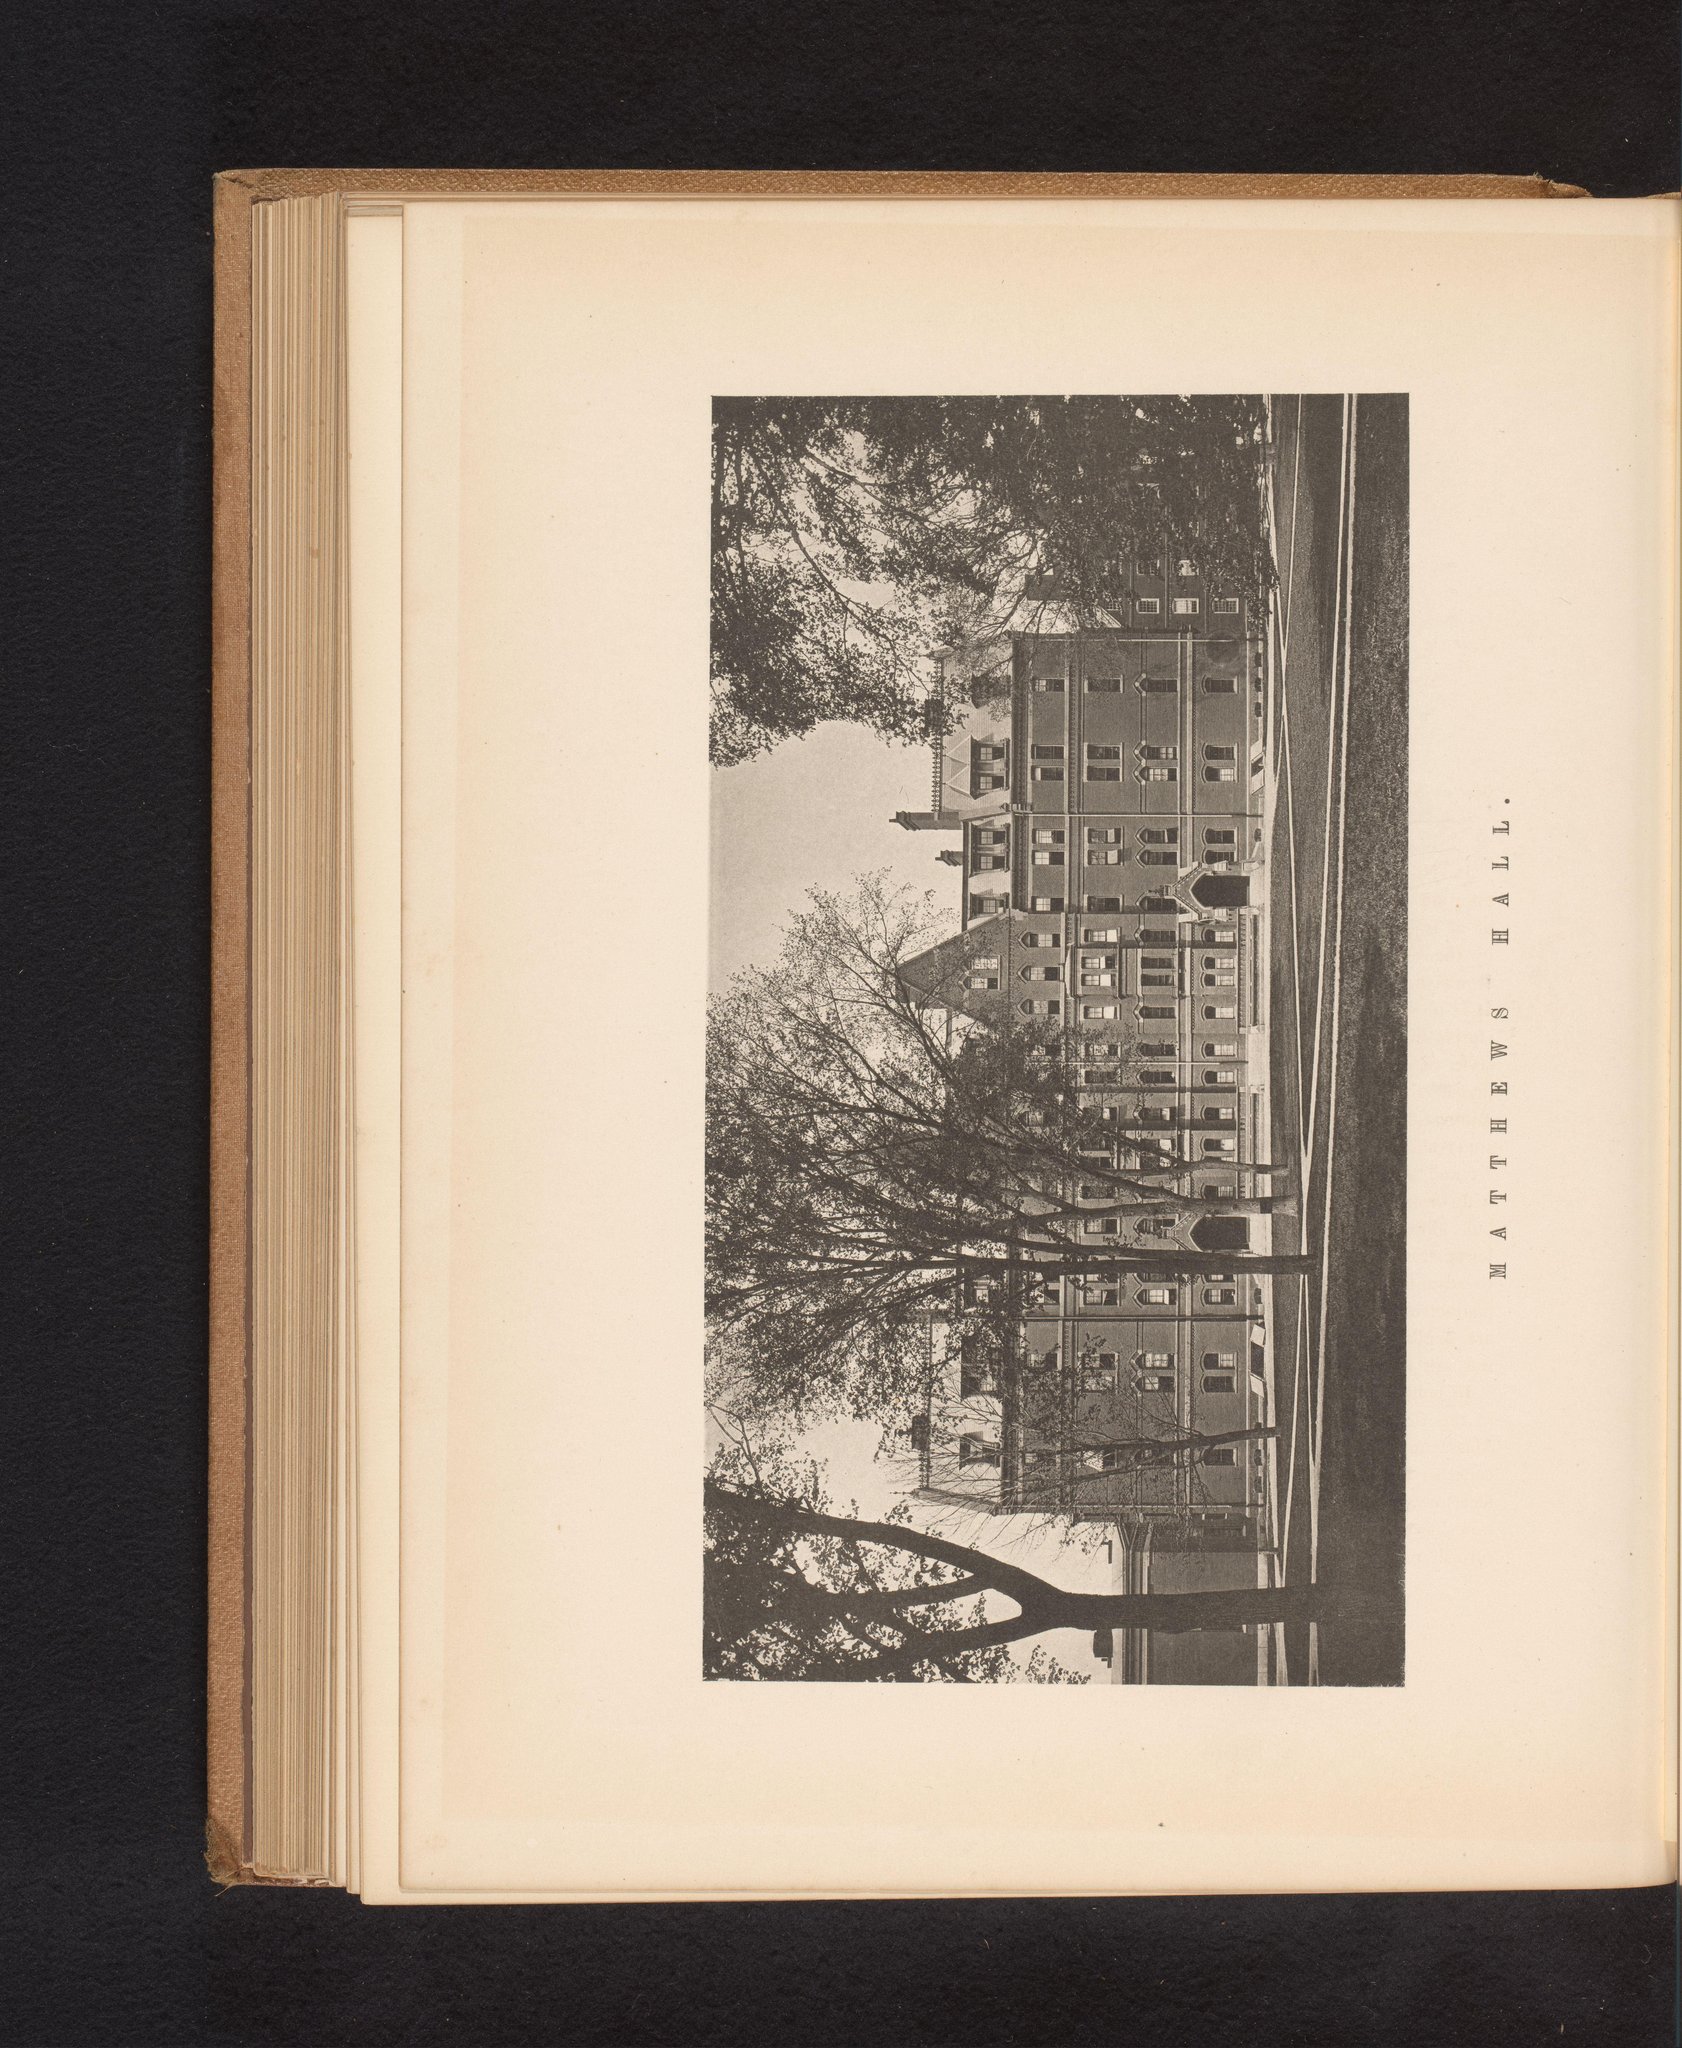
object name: page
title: Matthews Hall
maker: Anonymous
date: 1870-1875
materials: paper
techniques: photograph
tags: university building, college